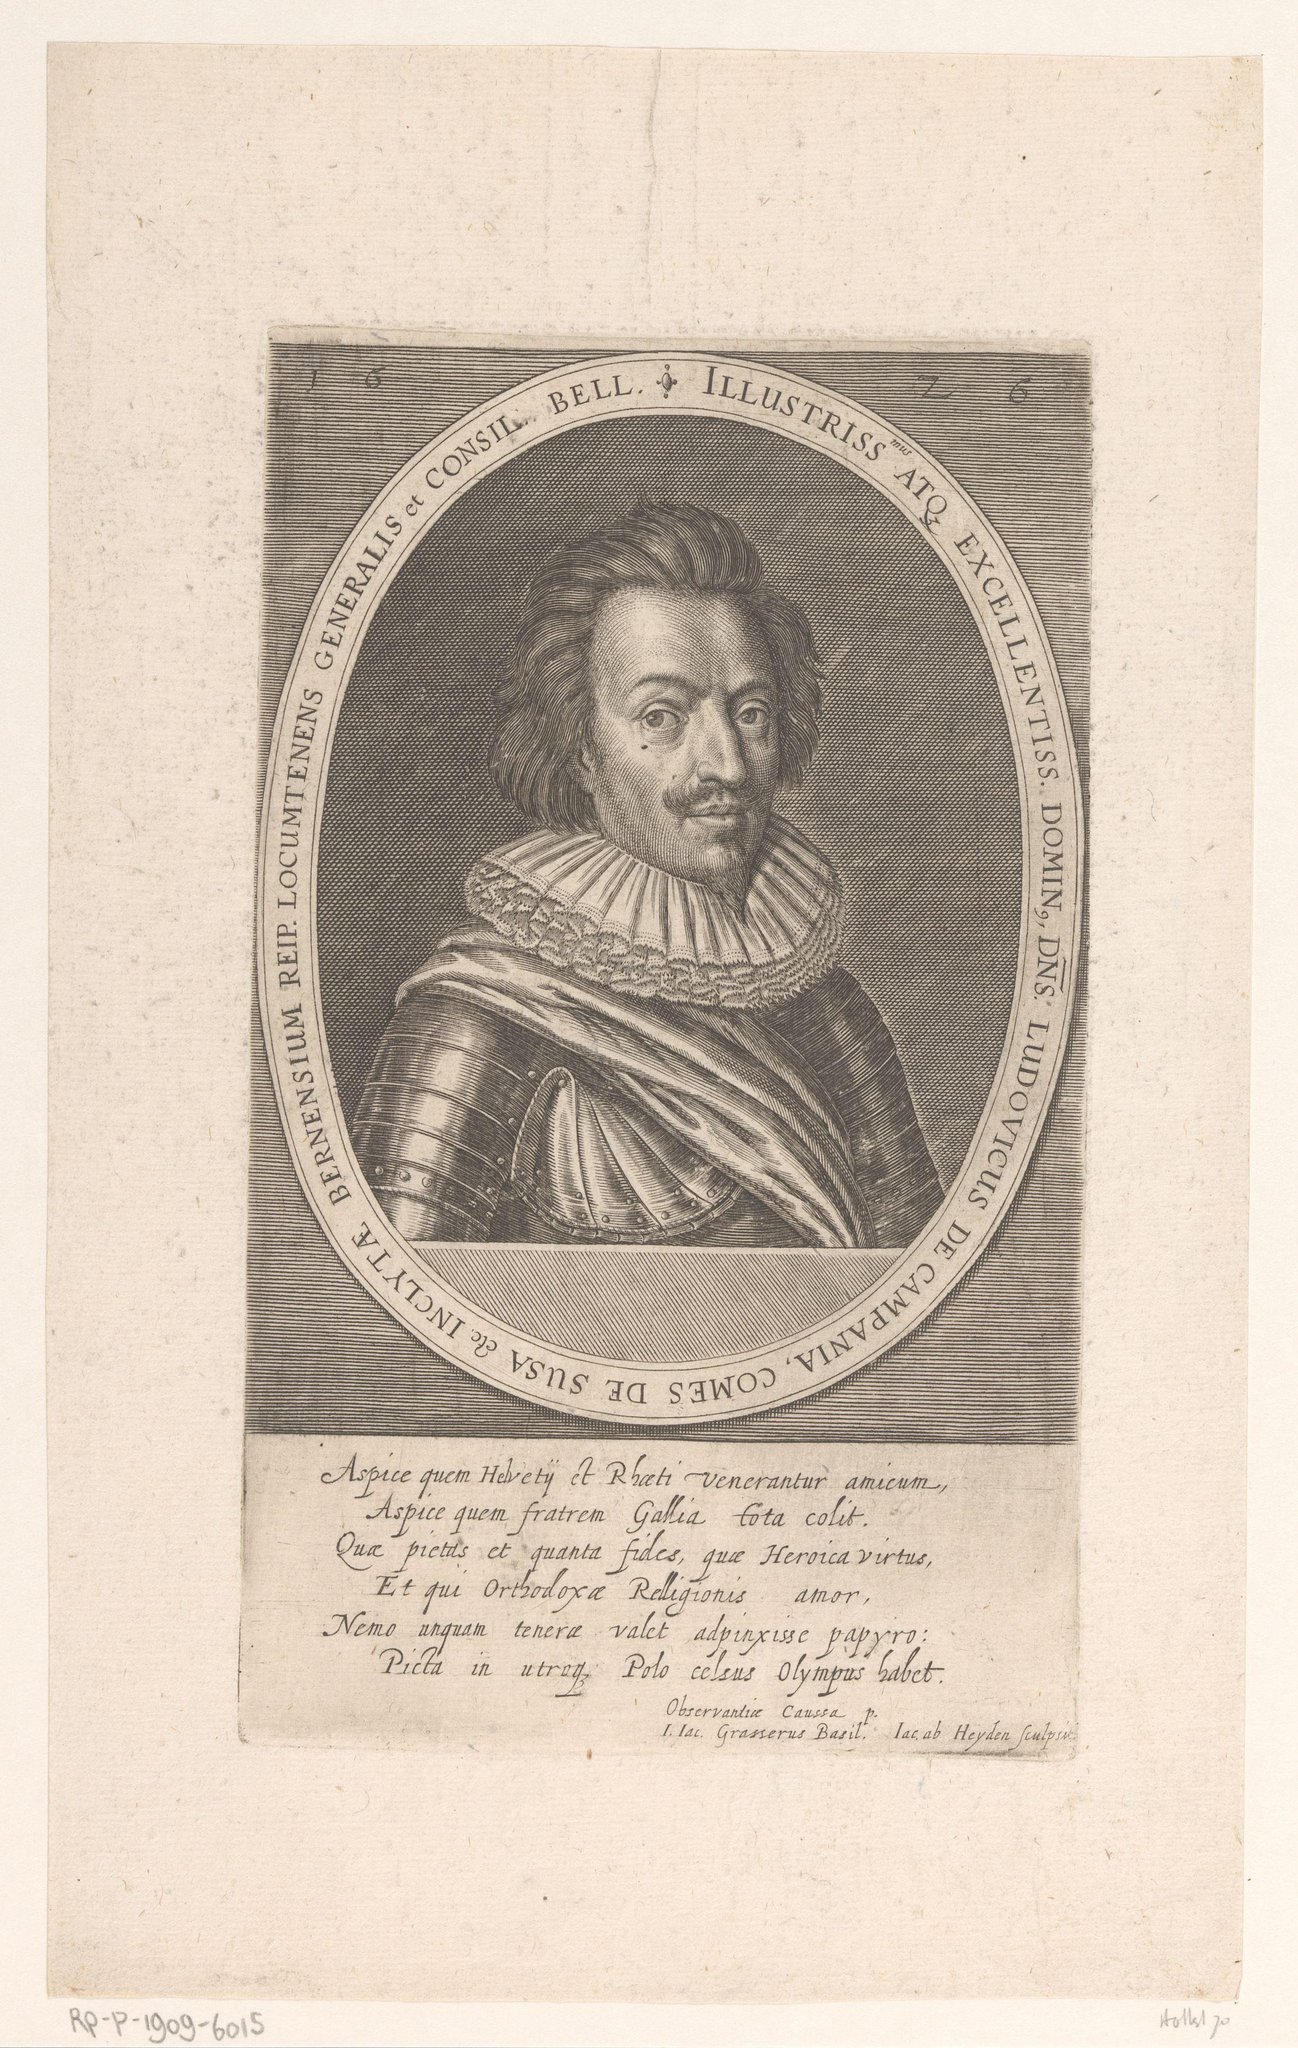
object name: print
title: Portret van Louis de Champagne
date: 1626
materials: paper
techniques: engraving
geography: basel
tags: armour, historical persons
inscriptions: collector's mark: Lugt 2228